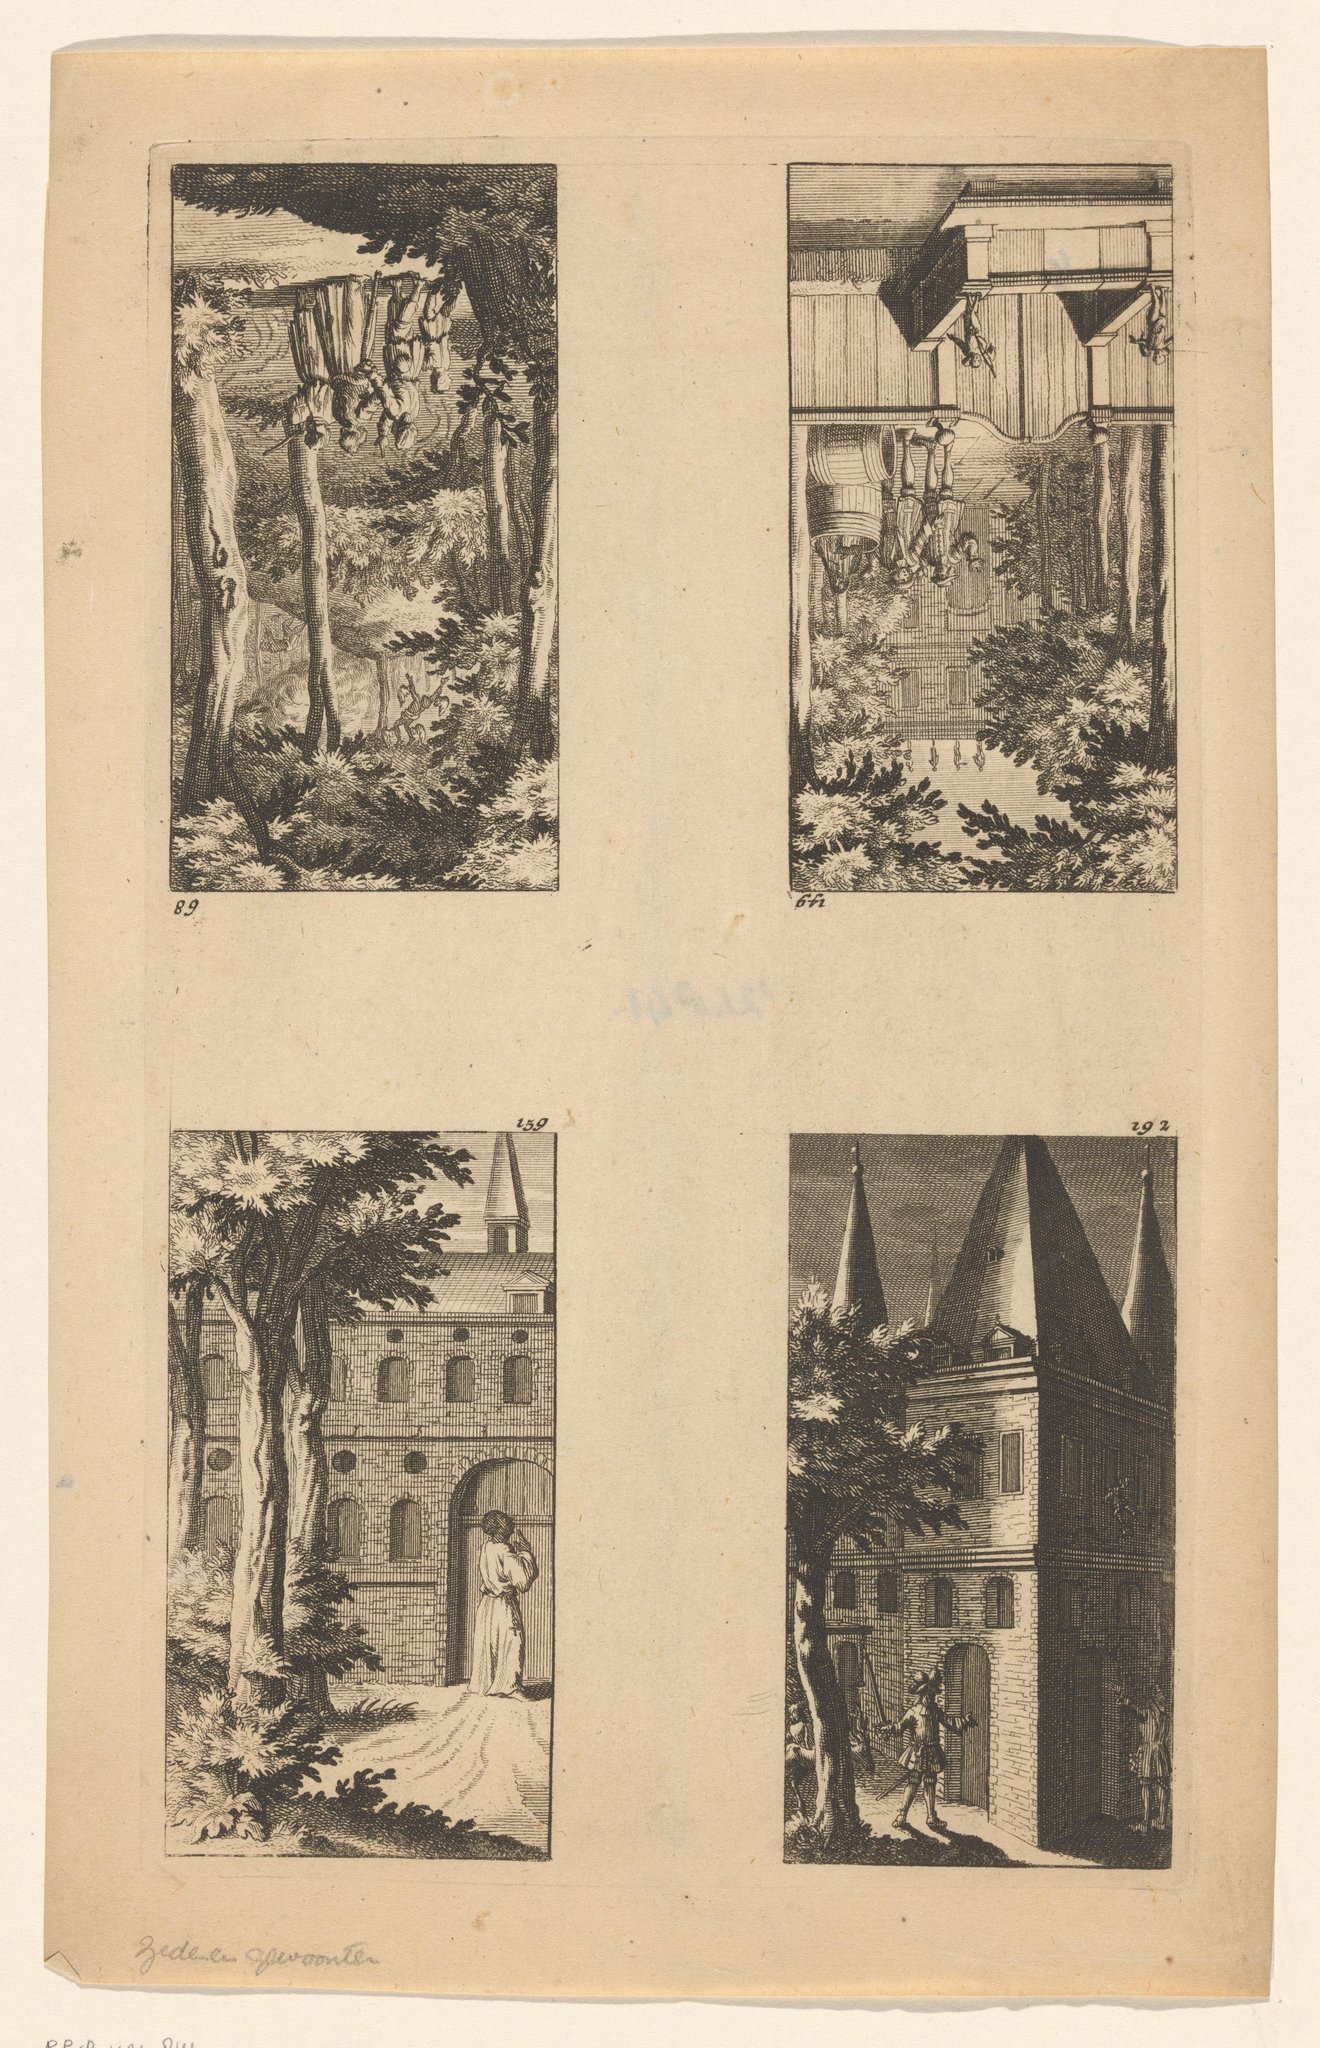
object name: print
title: Vier voorstellingen in een bos, bij een landhuis, een klooster en een kasteeltoren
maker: Anonymous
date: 1650-1750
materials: paper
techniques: etching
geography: northern netherlands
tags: abbey, monastery, convent ~ roman catholic church, forest, wood, villa, death i.e. the fall of icarus, without daedalus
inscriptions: collector's mark: Lugt 2233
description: De voorstellingen zijn rechtsboven genummerd: 68, 149, 159 en 192. Linksboven kijken vier figuren in het bos naar een vallende persoon met vleugels aan zijn enkels en armen: mogelijk de val van Icarus. Rechtsboven kijken twee figuren voor een landhuis naar iemand die uit een waterton komt. Linksonder staat een monnik bij een gesloten poort. Rechtsonder gewapende figuren bij een toren.